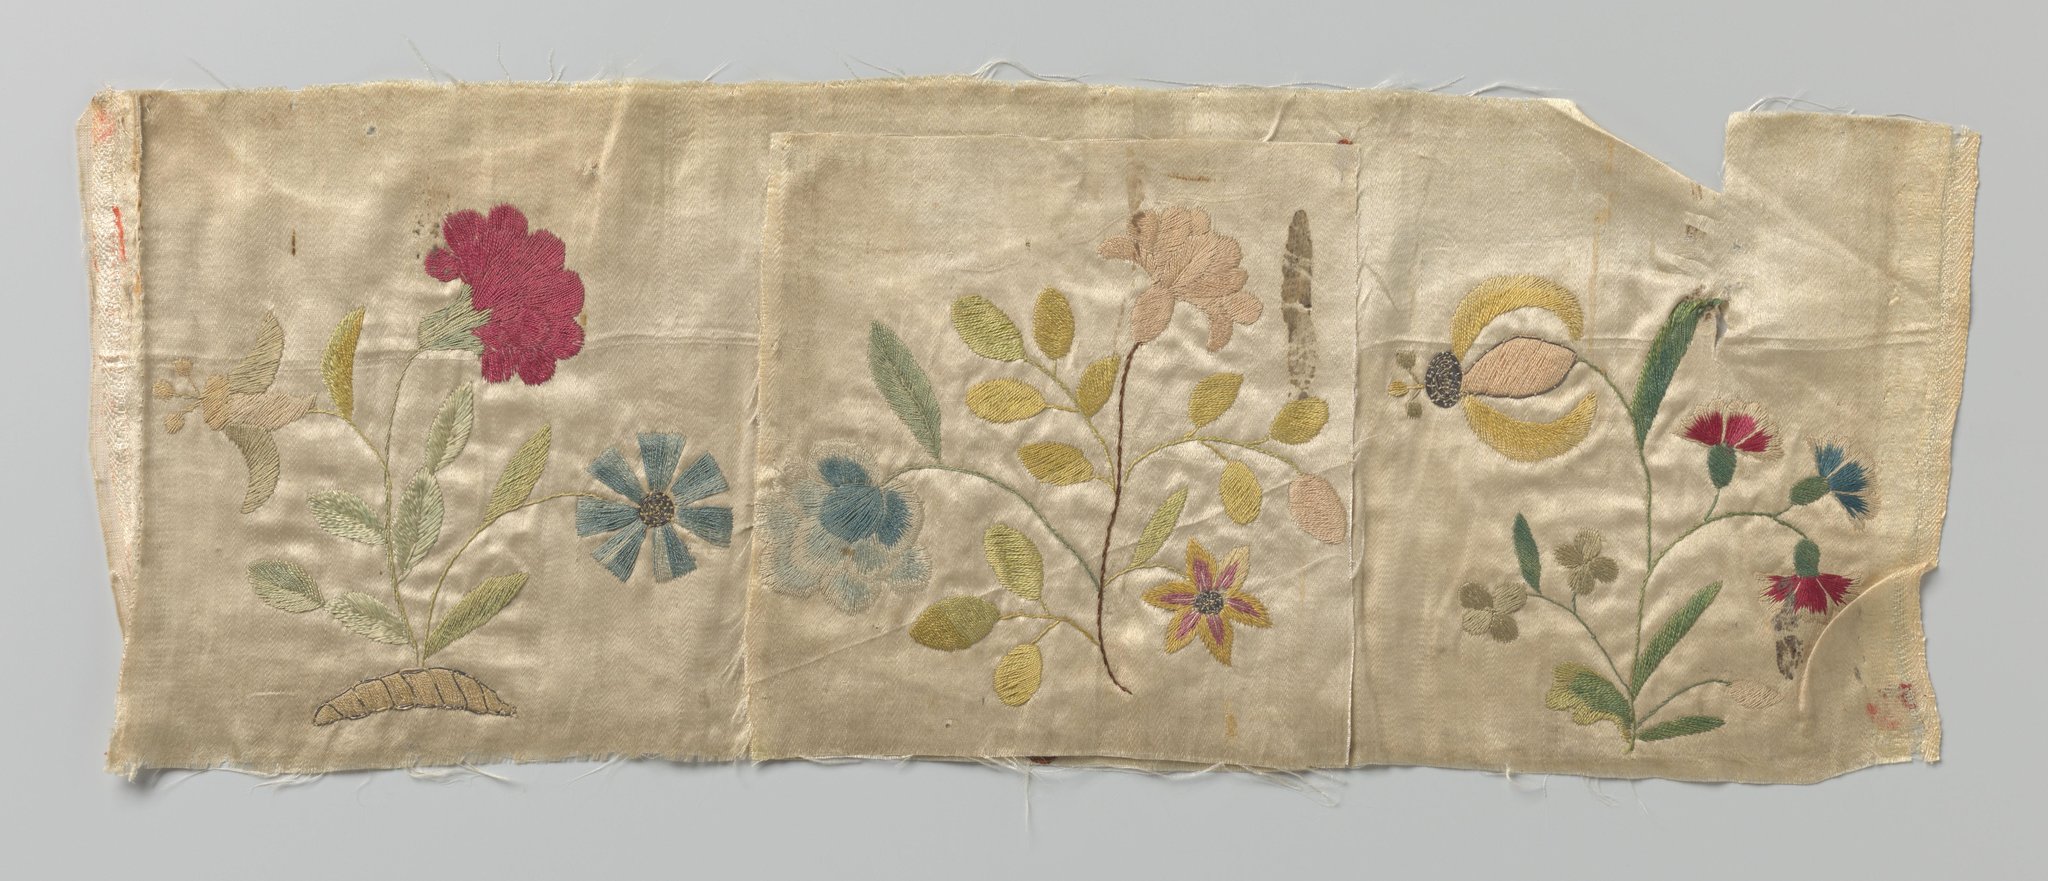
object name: embroidery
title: Fragment van wit satijn, waarop gekleurde zijden bloemen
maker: Anonymous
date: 1400-1950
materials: silk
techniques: embroidered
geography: netherlands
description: Fragment wit zijdeweefsel, met veelkleurig borduurwerk. Het fragment bestaat uit drie aaneengenaaide fragmenten. Op het fragment zijn drie veelkleurige bloemtakken geborduurd.